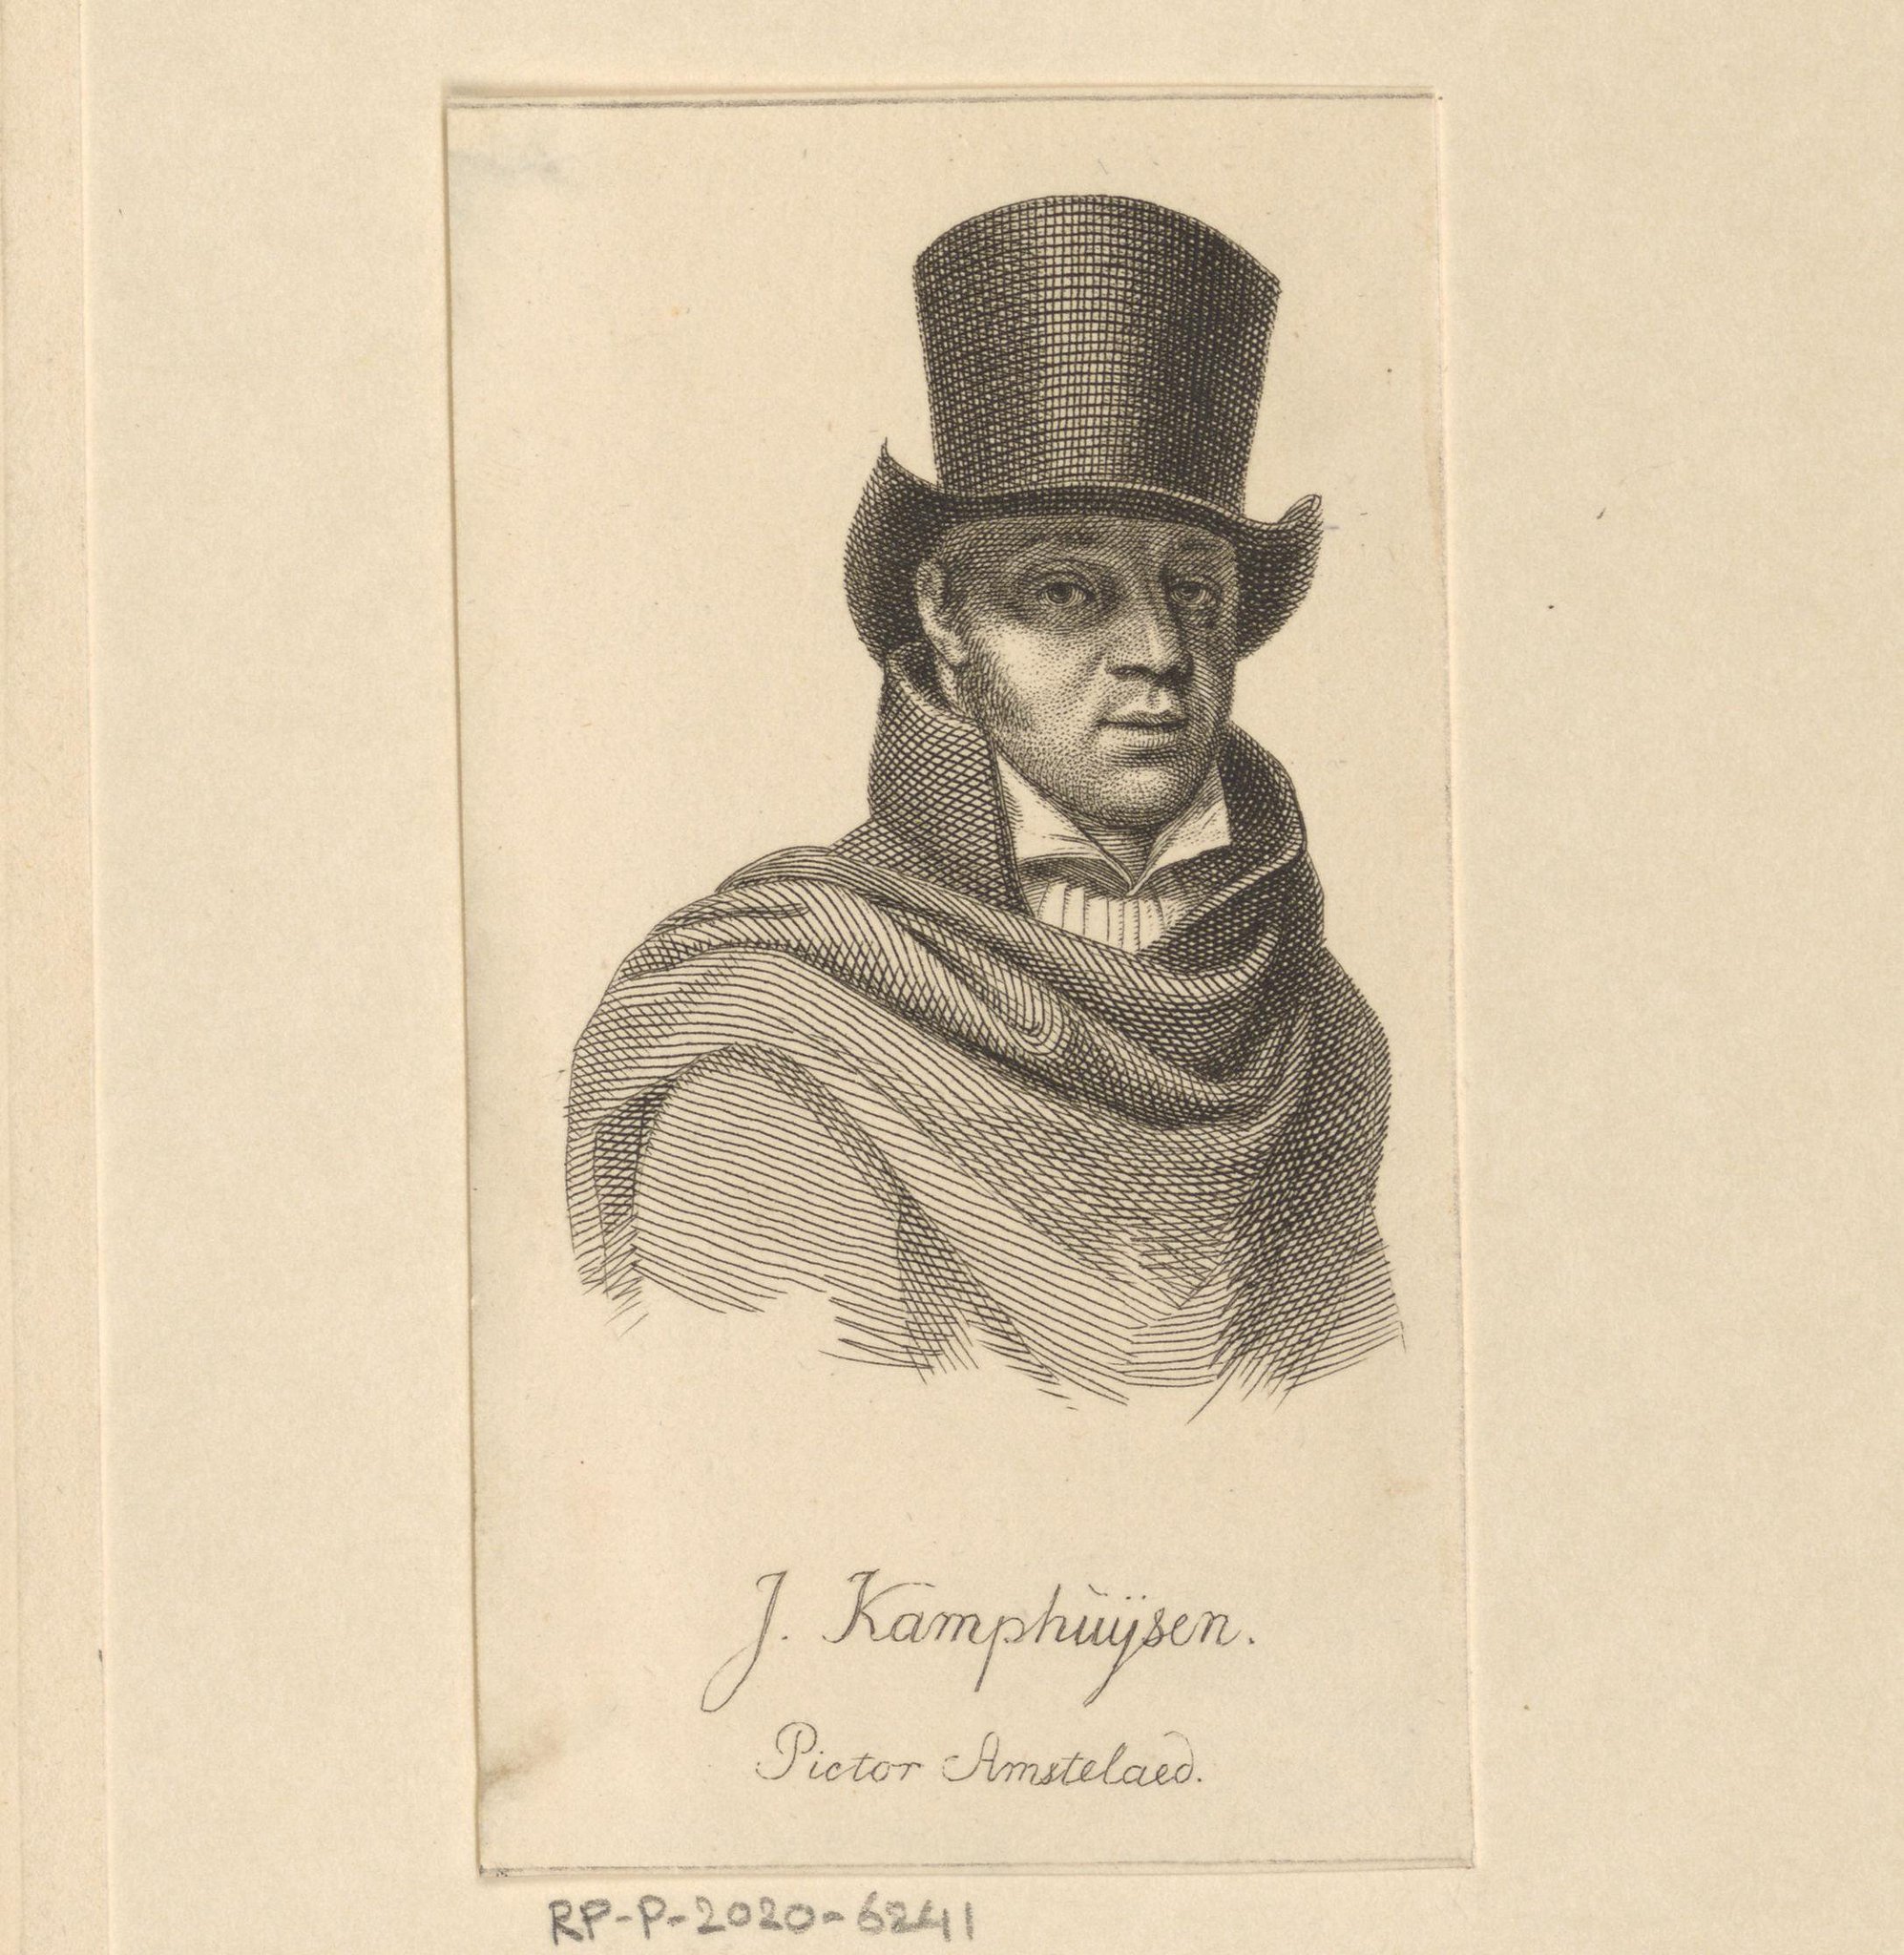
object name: print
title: Portret van Jan Kamphuijsen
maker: jacob ernst marcus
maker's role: draughtsman, print maker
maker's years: 1774-1826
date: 1785-1826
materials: paper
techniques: etching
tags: amsterdam, painter, draughtsman, jan kamphuijsen, historical persons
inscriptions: collector's mark: Lugt 924